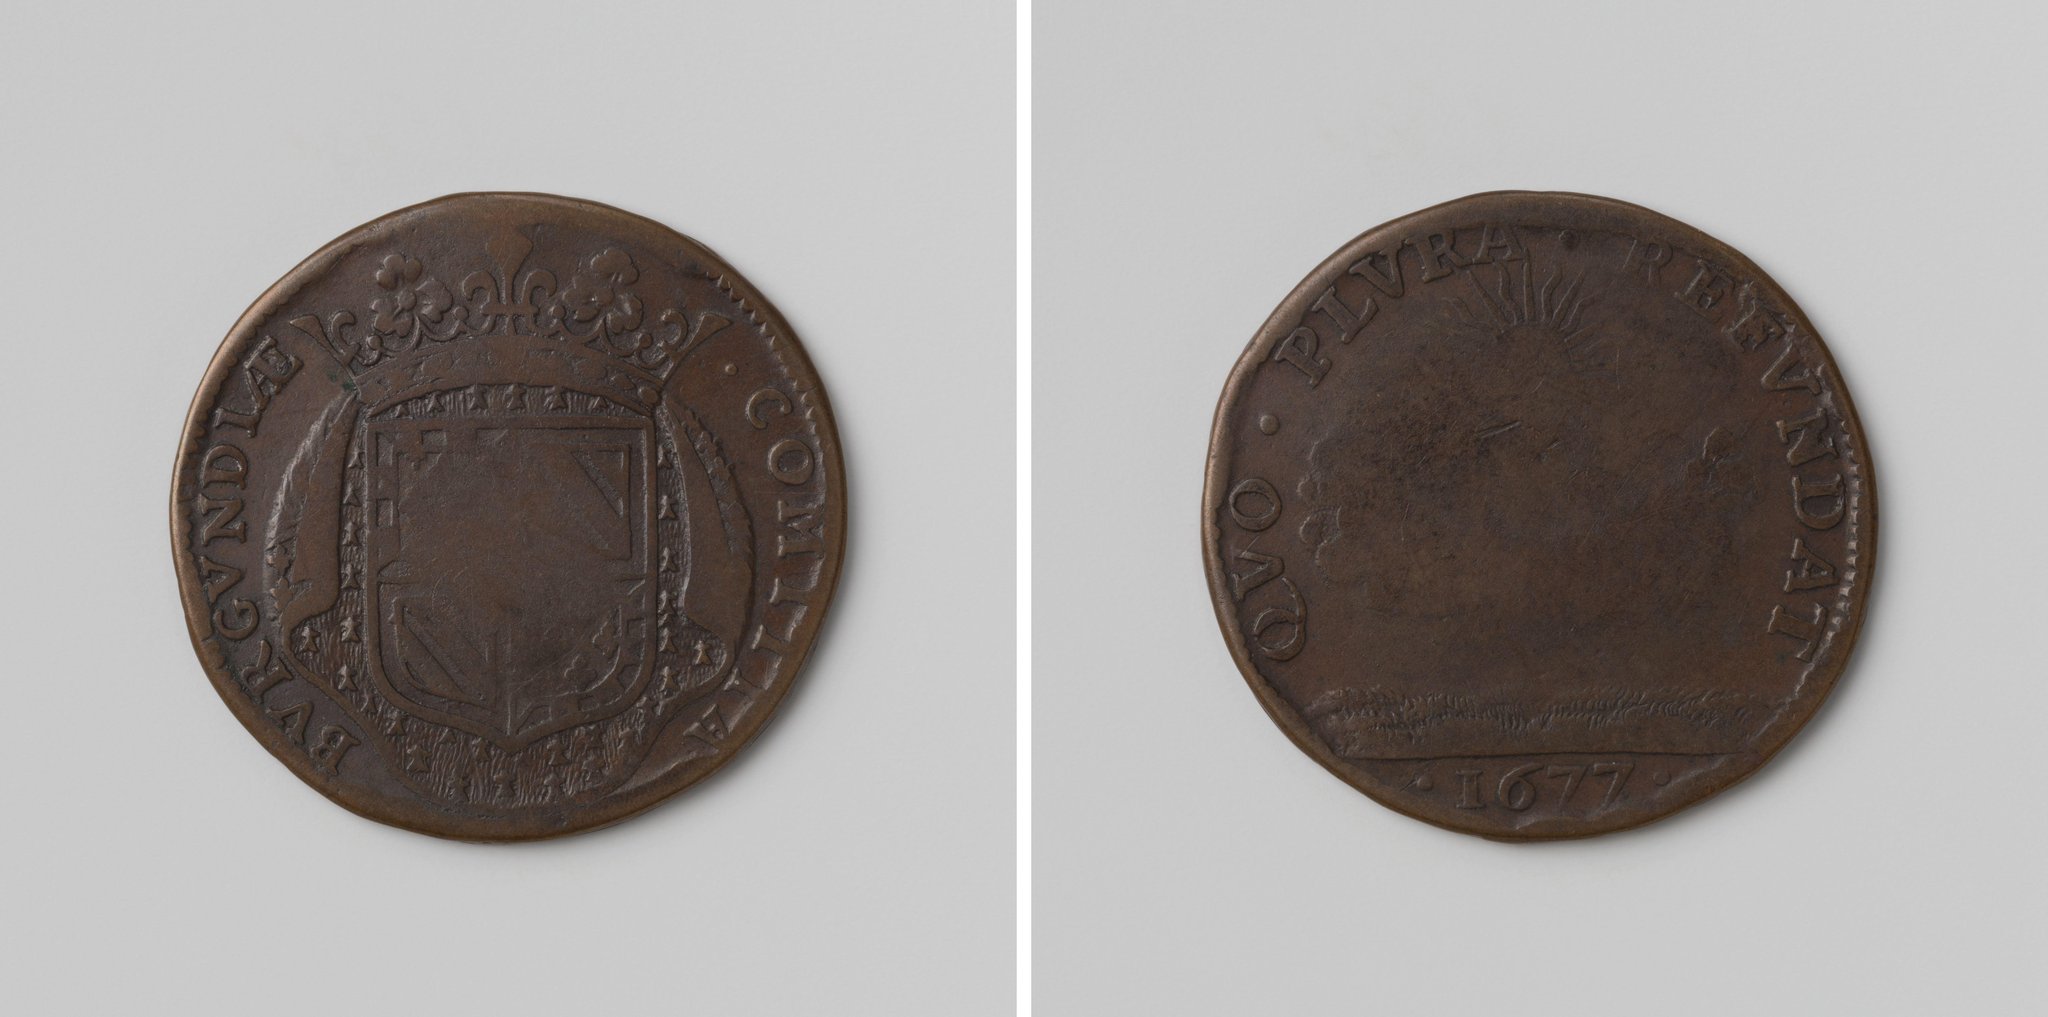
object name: jeton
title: Graafschap van Bourgondië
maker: Anonymous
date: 1677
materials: copper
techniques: striking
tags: bourgondië